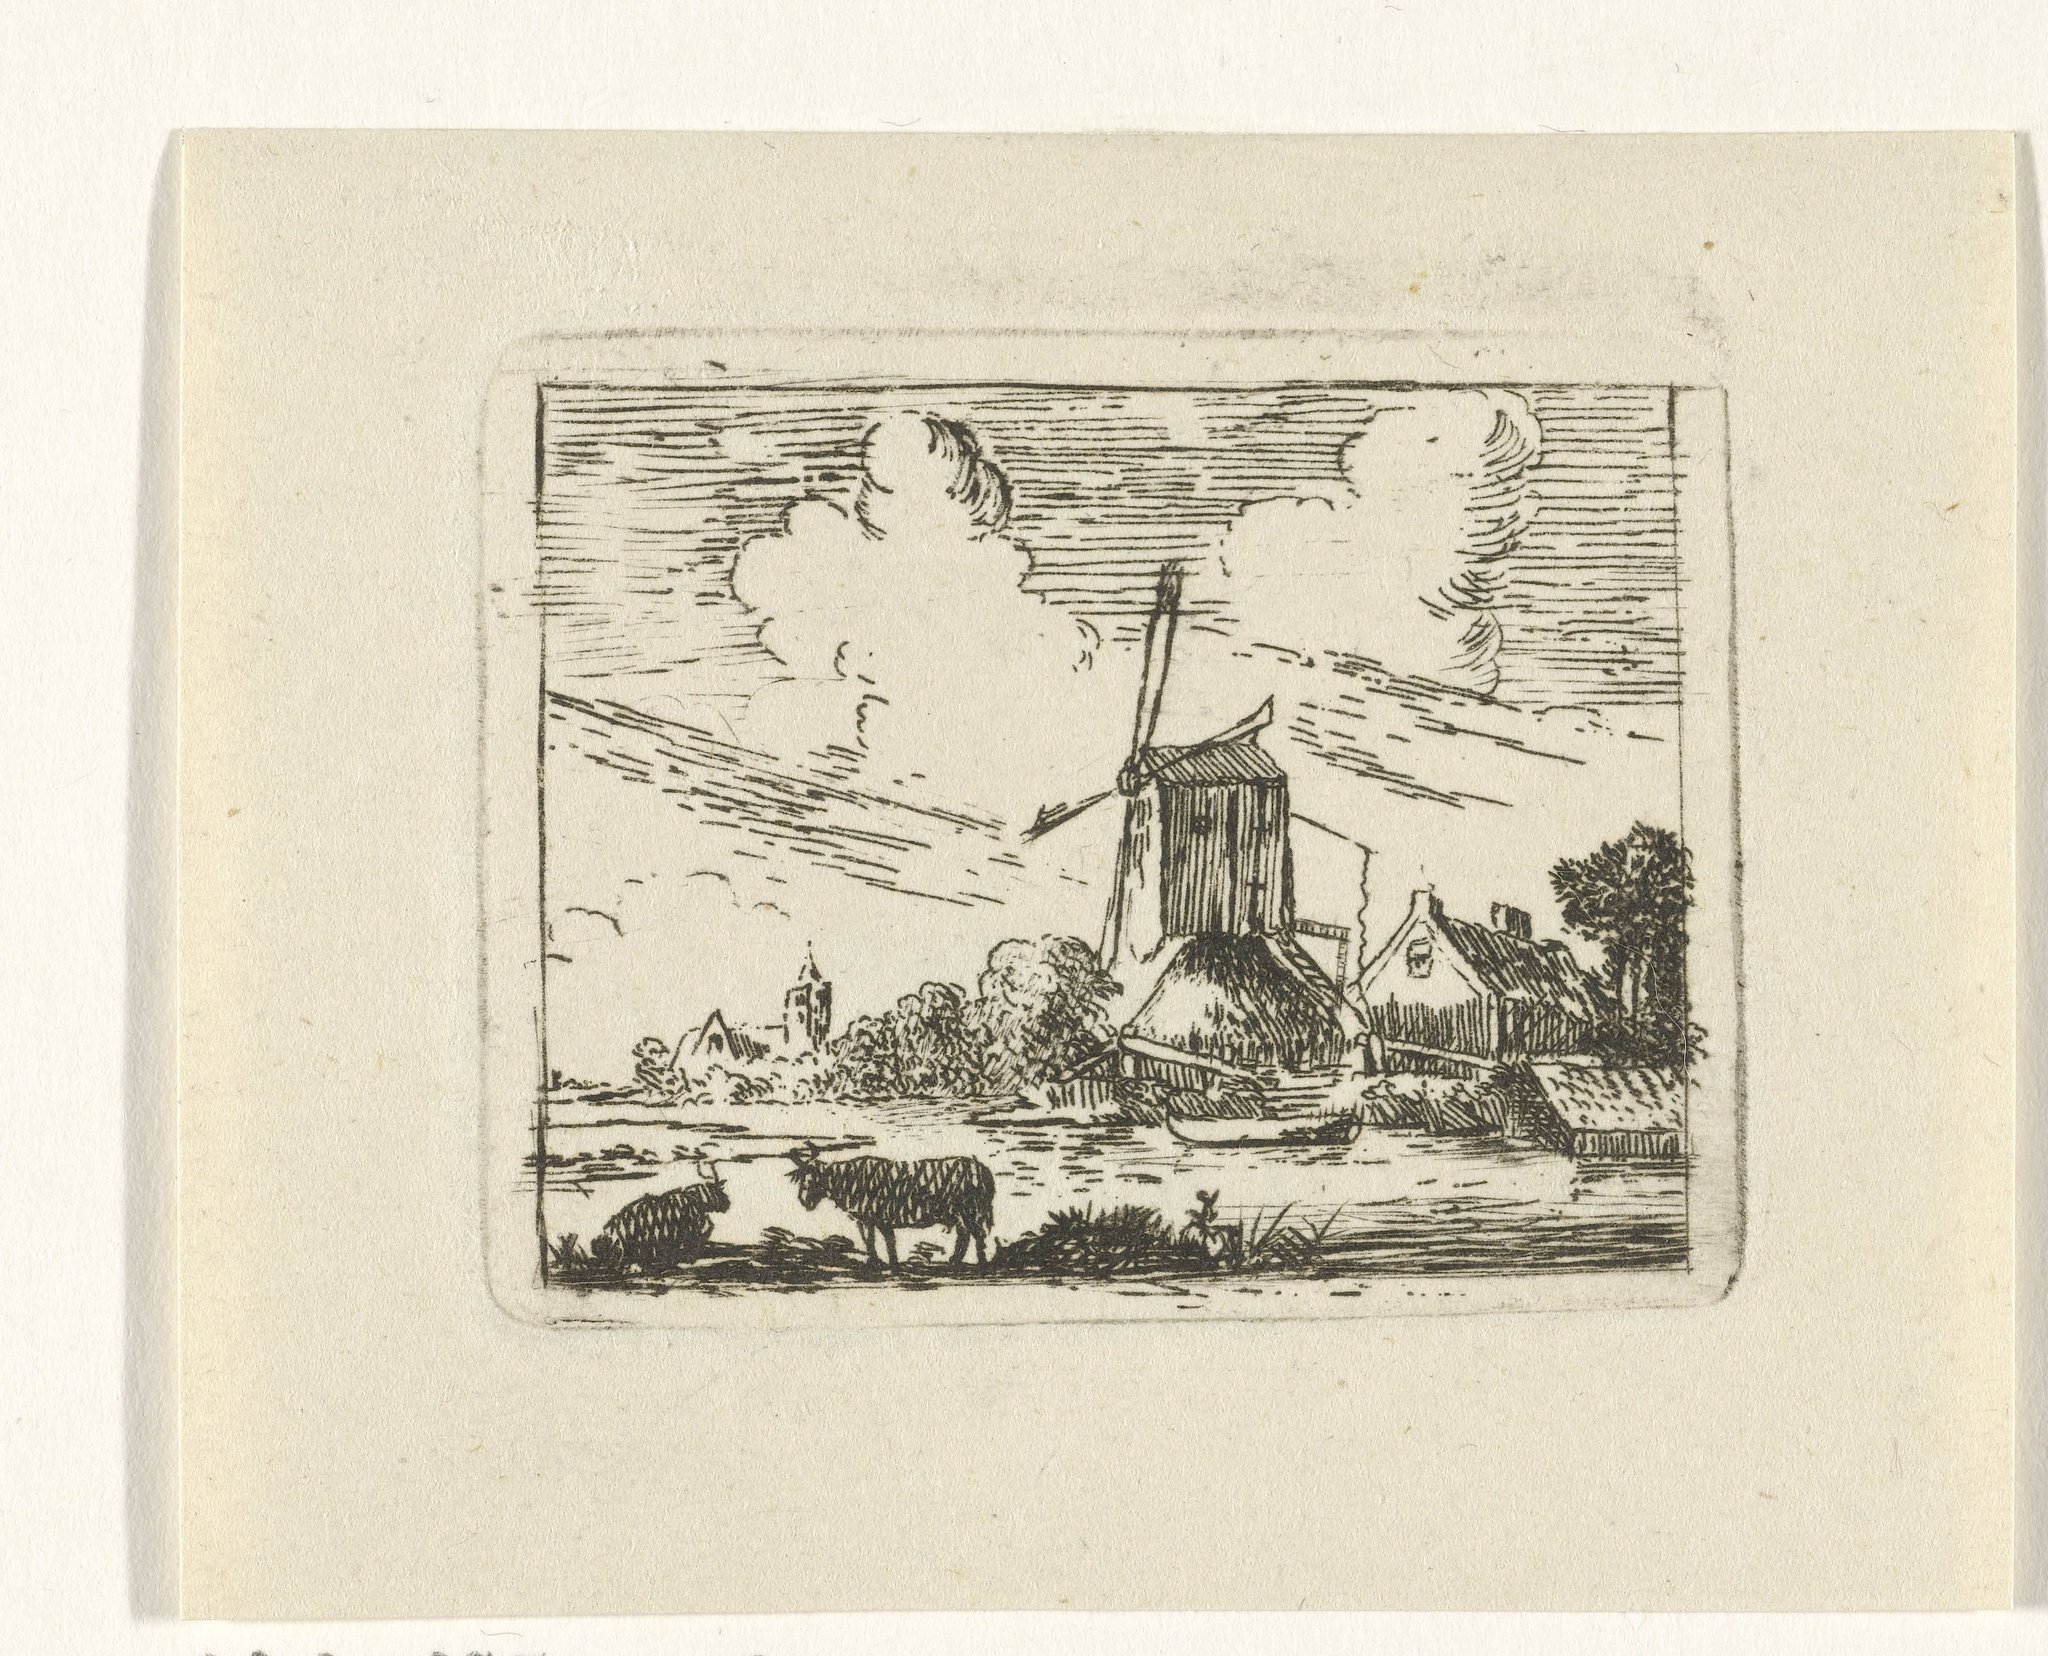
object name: print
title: Koeien aan een oever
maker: simon klapmuts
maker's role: print maker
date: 1744-1780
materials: paper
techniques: etching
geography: moordrecht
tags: cow, landscapes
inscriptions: collector's mark: Lugt 2228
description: Aan de oever van een rivier twee koeien, waarvan er één staat en de tweede ligt. Op de achtergrond een huis en een molen en links een kerktoren.